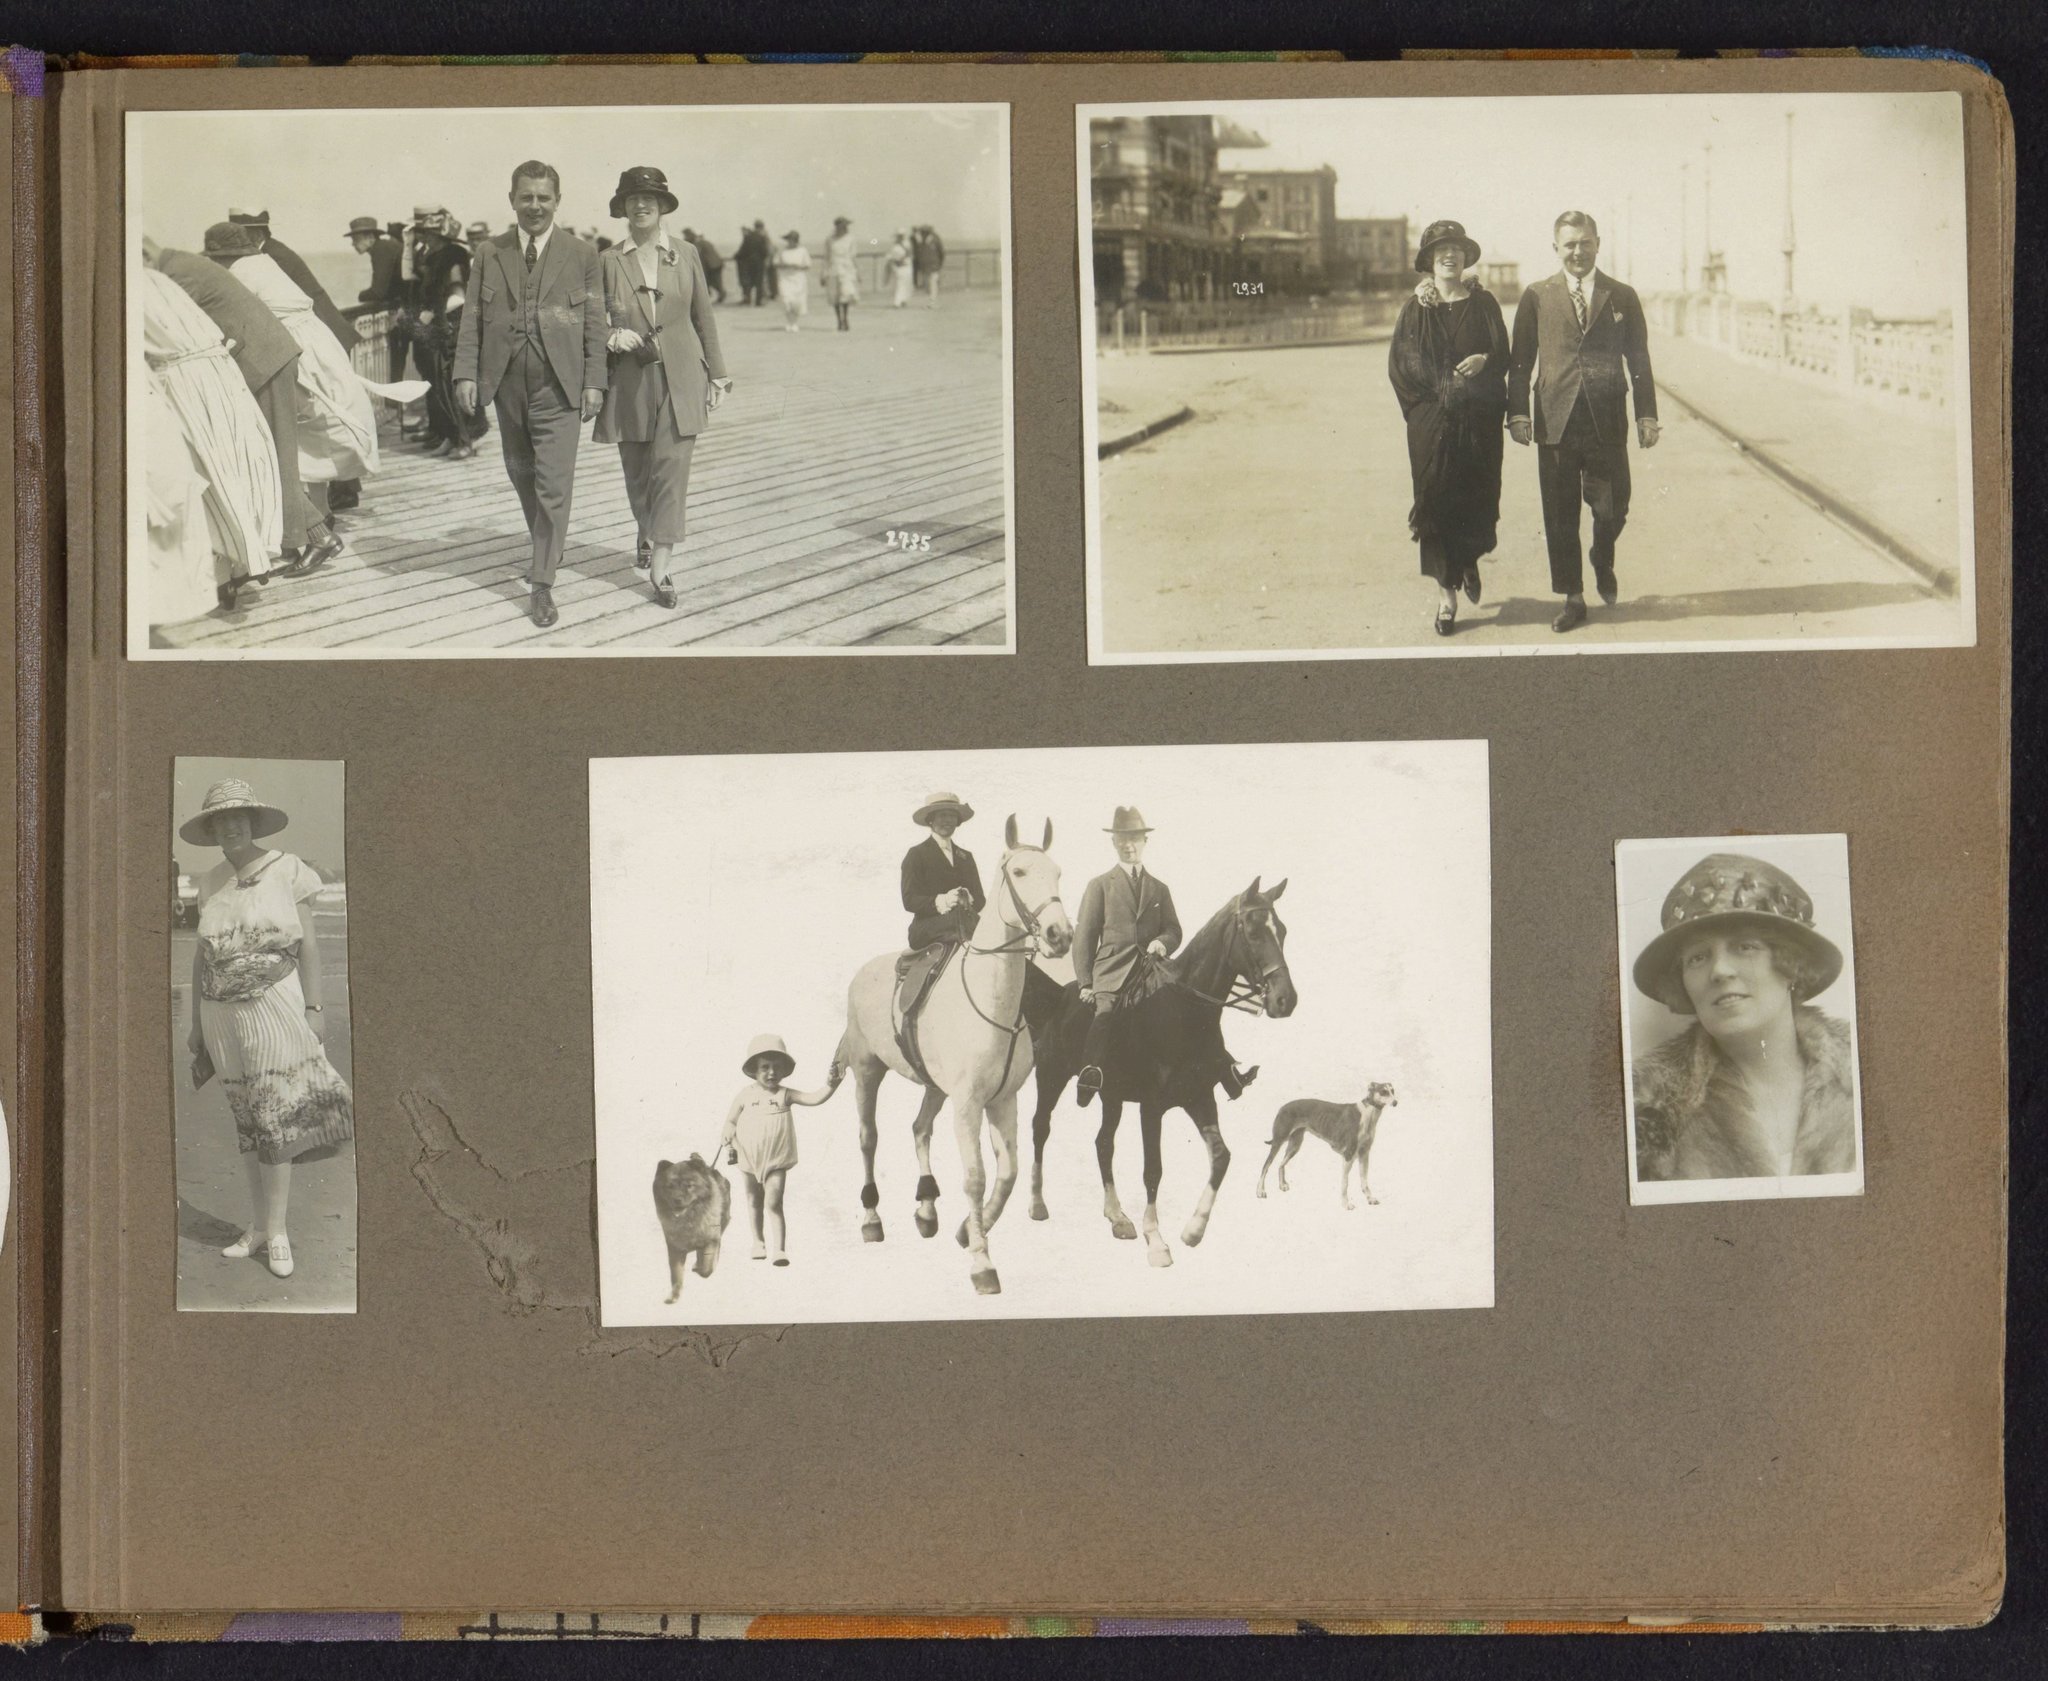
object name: photograph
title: Familiefoto's, onder meer in Scheveningen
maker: Anonymous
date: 1900-1925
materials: cardboard, photographic support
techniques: gelatin silver print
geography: netherlands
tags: riding a horse, ass, or mule; rider, horseman, marriage, married couple, 'matrimonium'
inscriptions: number: ‘2931’, number: ‘2735’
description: Albumblad met twee foto's van hetzelfde stel, wandelend op de pier en de boulevard van Scheveningen. Ook twee portretten van een vrouw en een compositiefoto van een paardrijdend stel begeleid door een kind en honden. Onderdeel van Fotoalbum van een onbekende Nederlandse familie met connecties in Suriname en Nederlands-Indië (1).